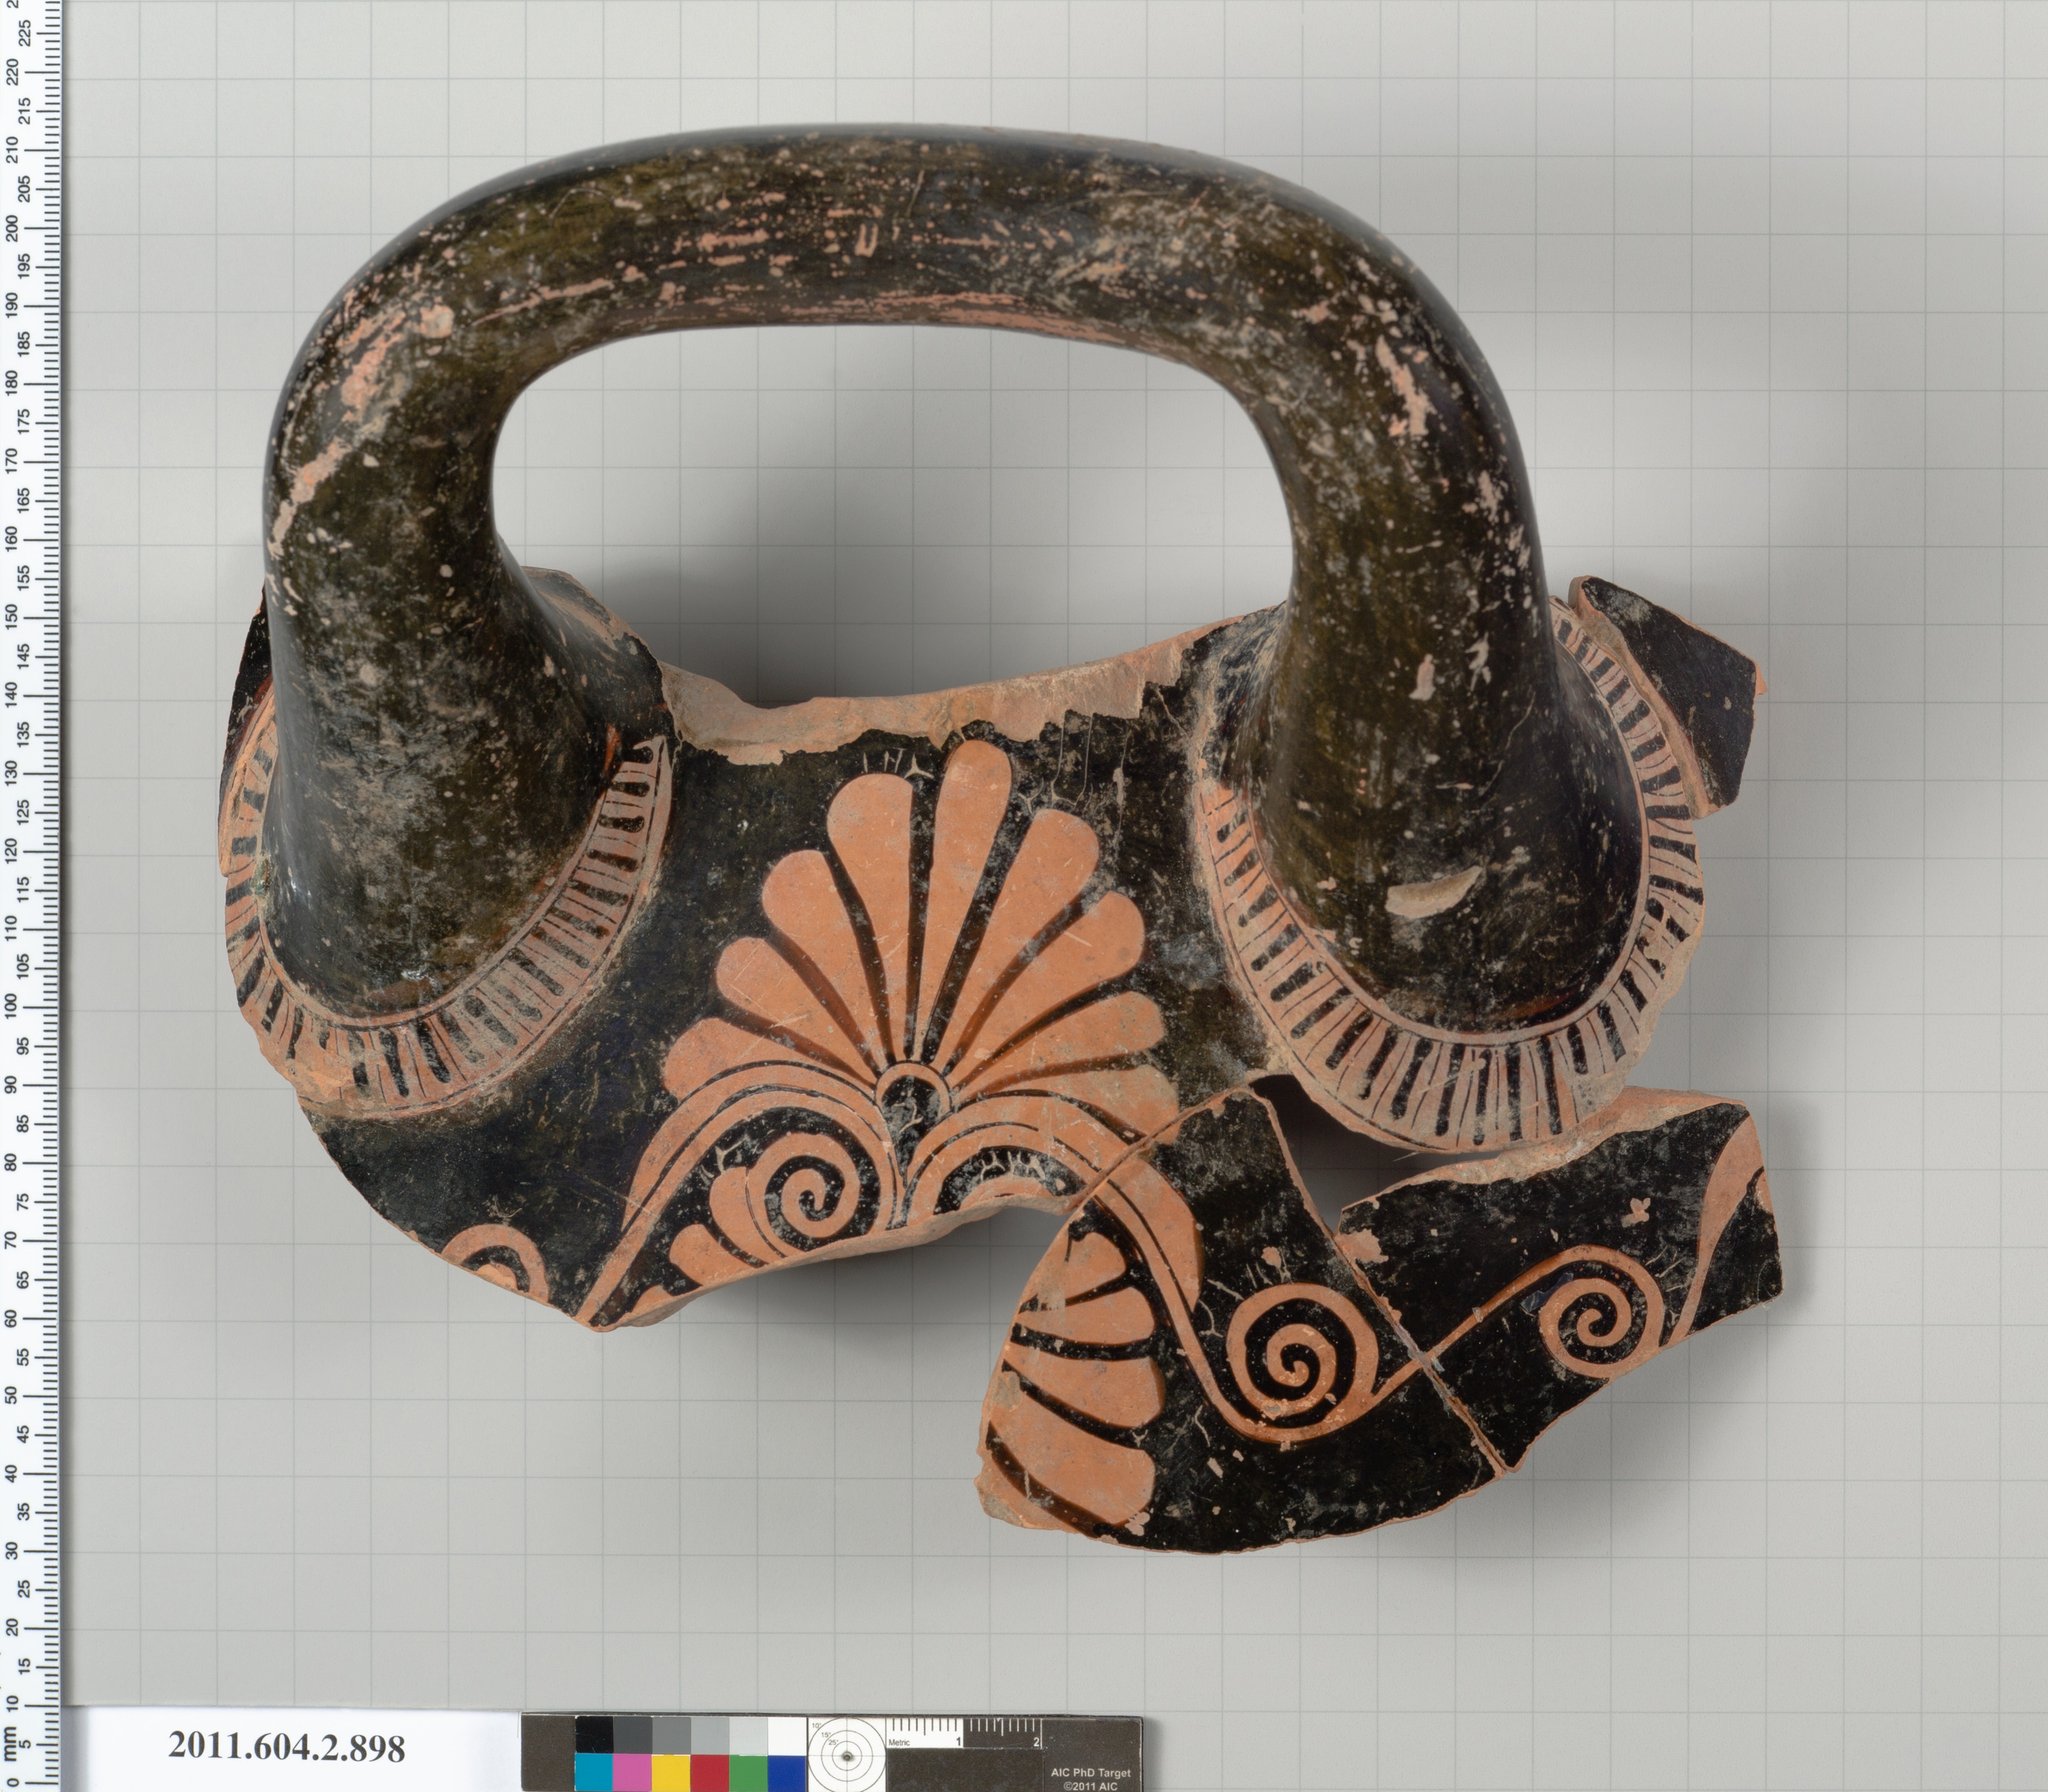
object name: bell krater fragment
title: Terracotta fragment of a bell-krater (bowl for mixing wine and water)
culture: greek, attic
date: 467-435 BCE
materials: terracotta